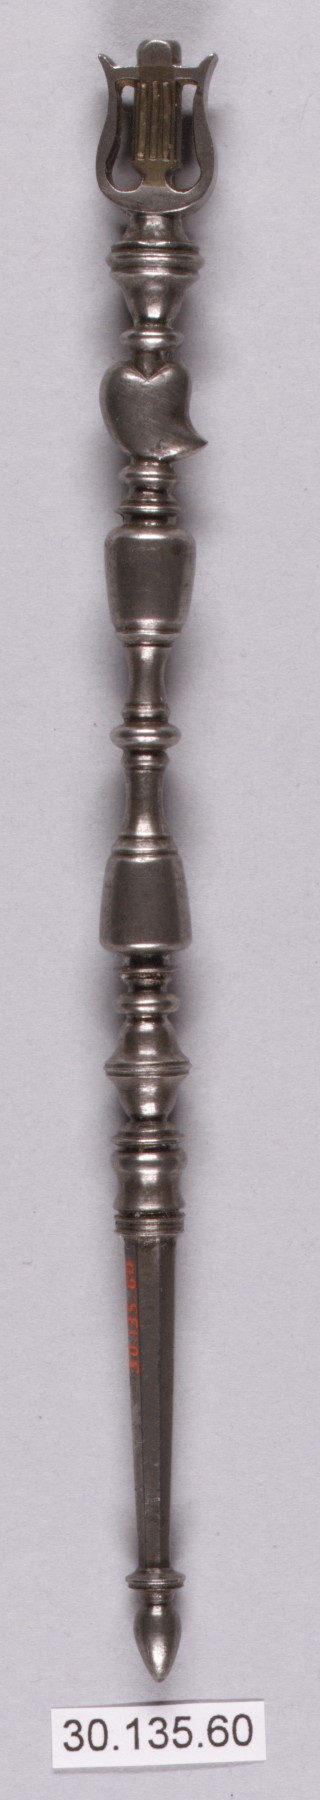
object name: needle sheath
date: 1601-1700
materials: steel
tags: lyres